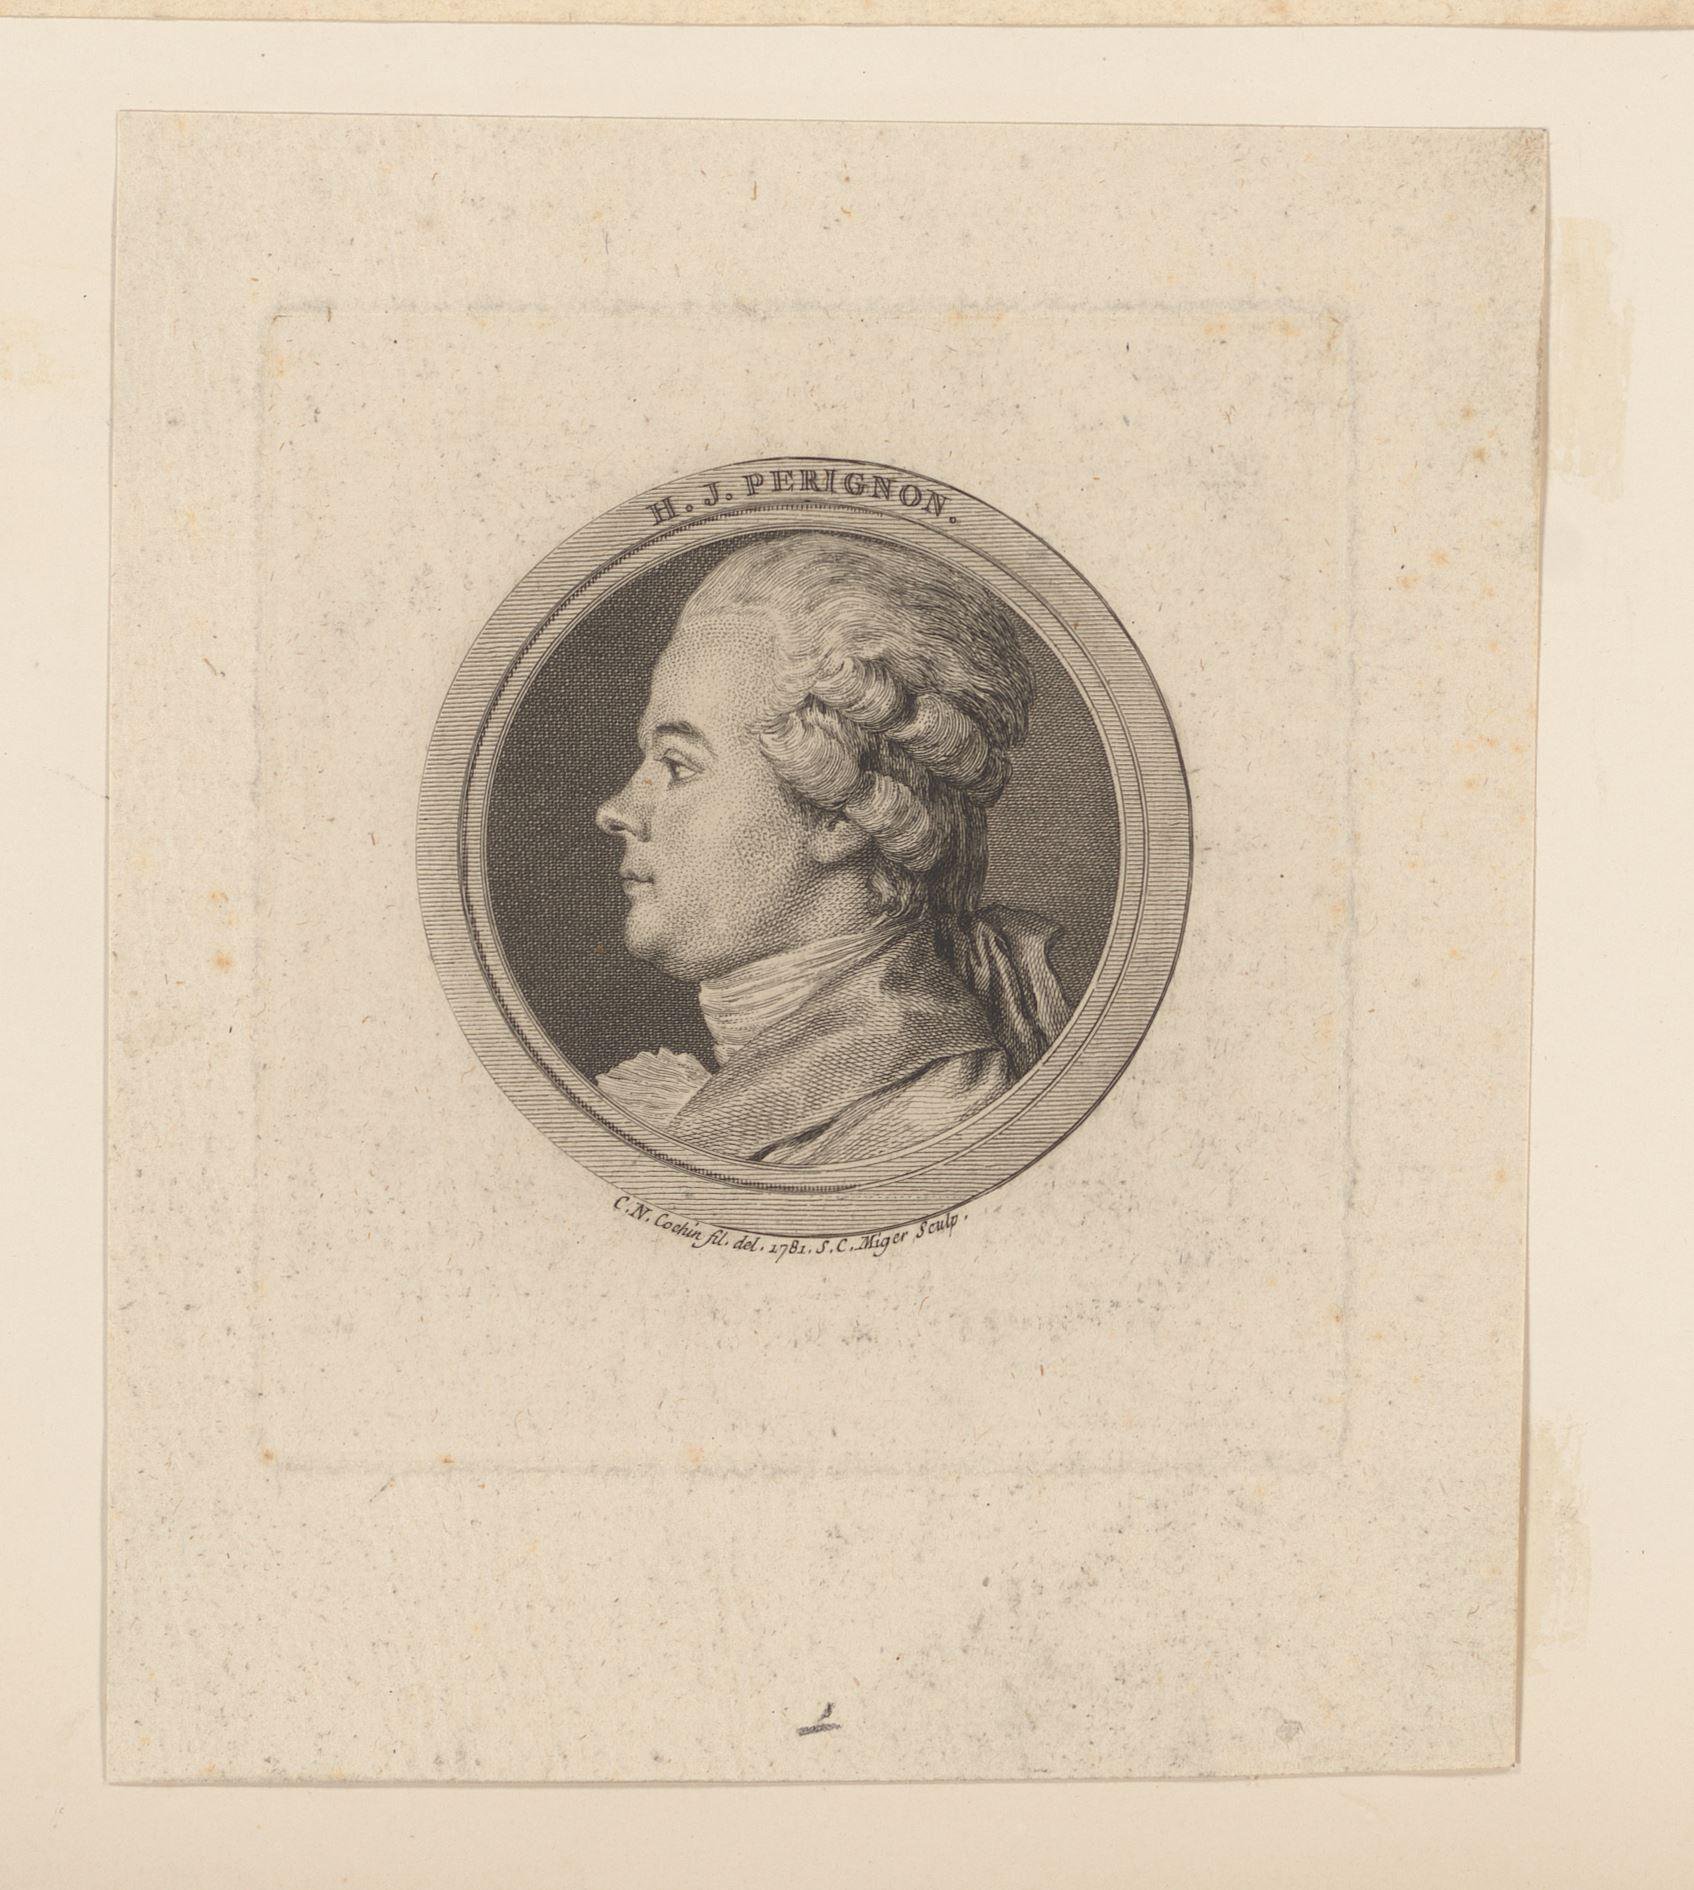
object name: album leaf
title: Portret van Henri-Joseph Pérignon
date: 1781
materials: paper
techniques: engraving, etching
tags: historical persons, portrait of a musician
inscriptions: date